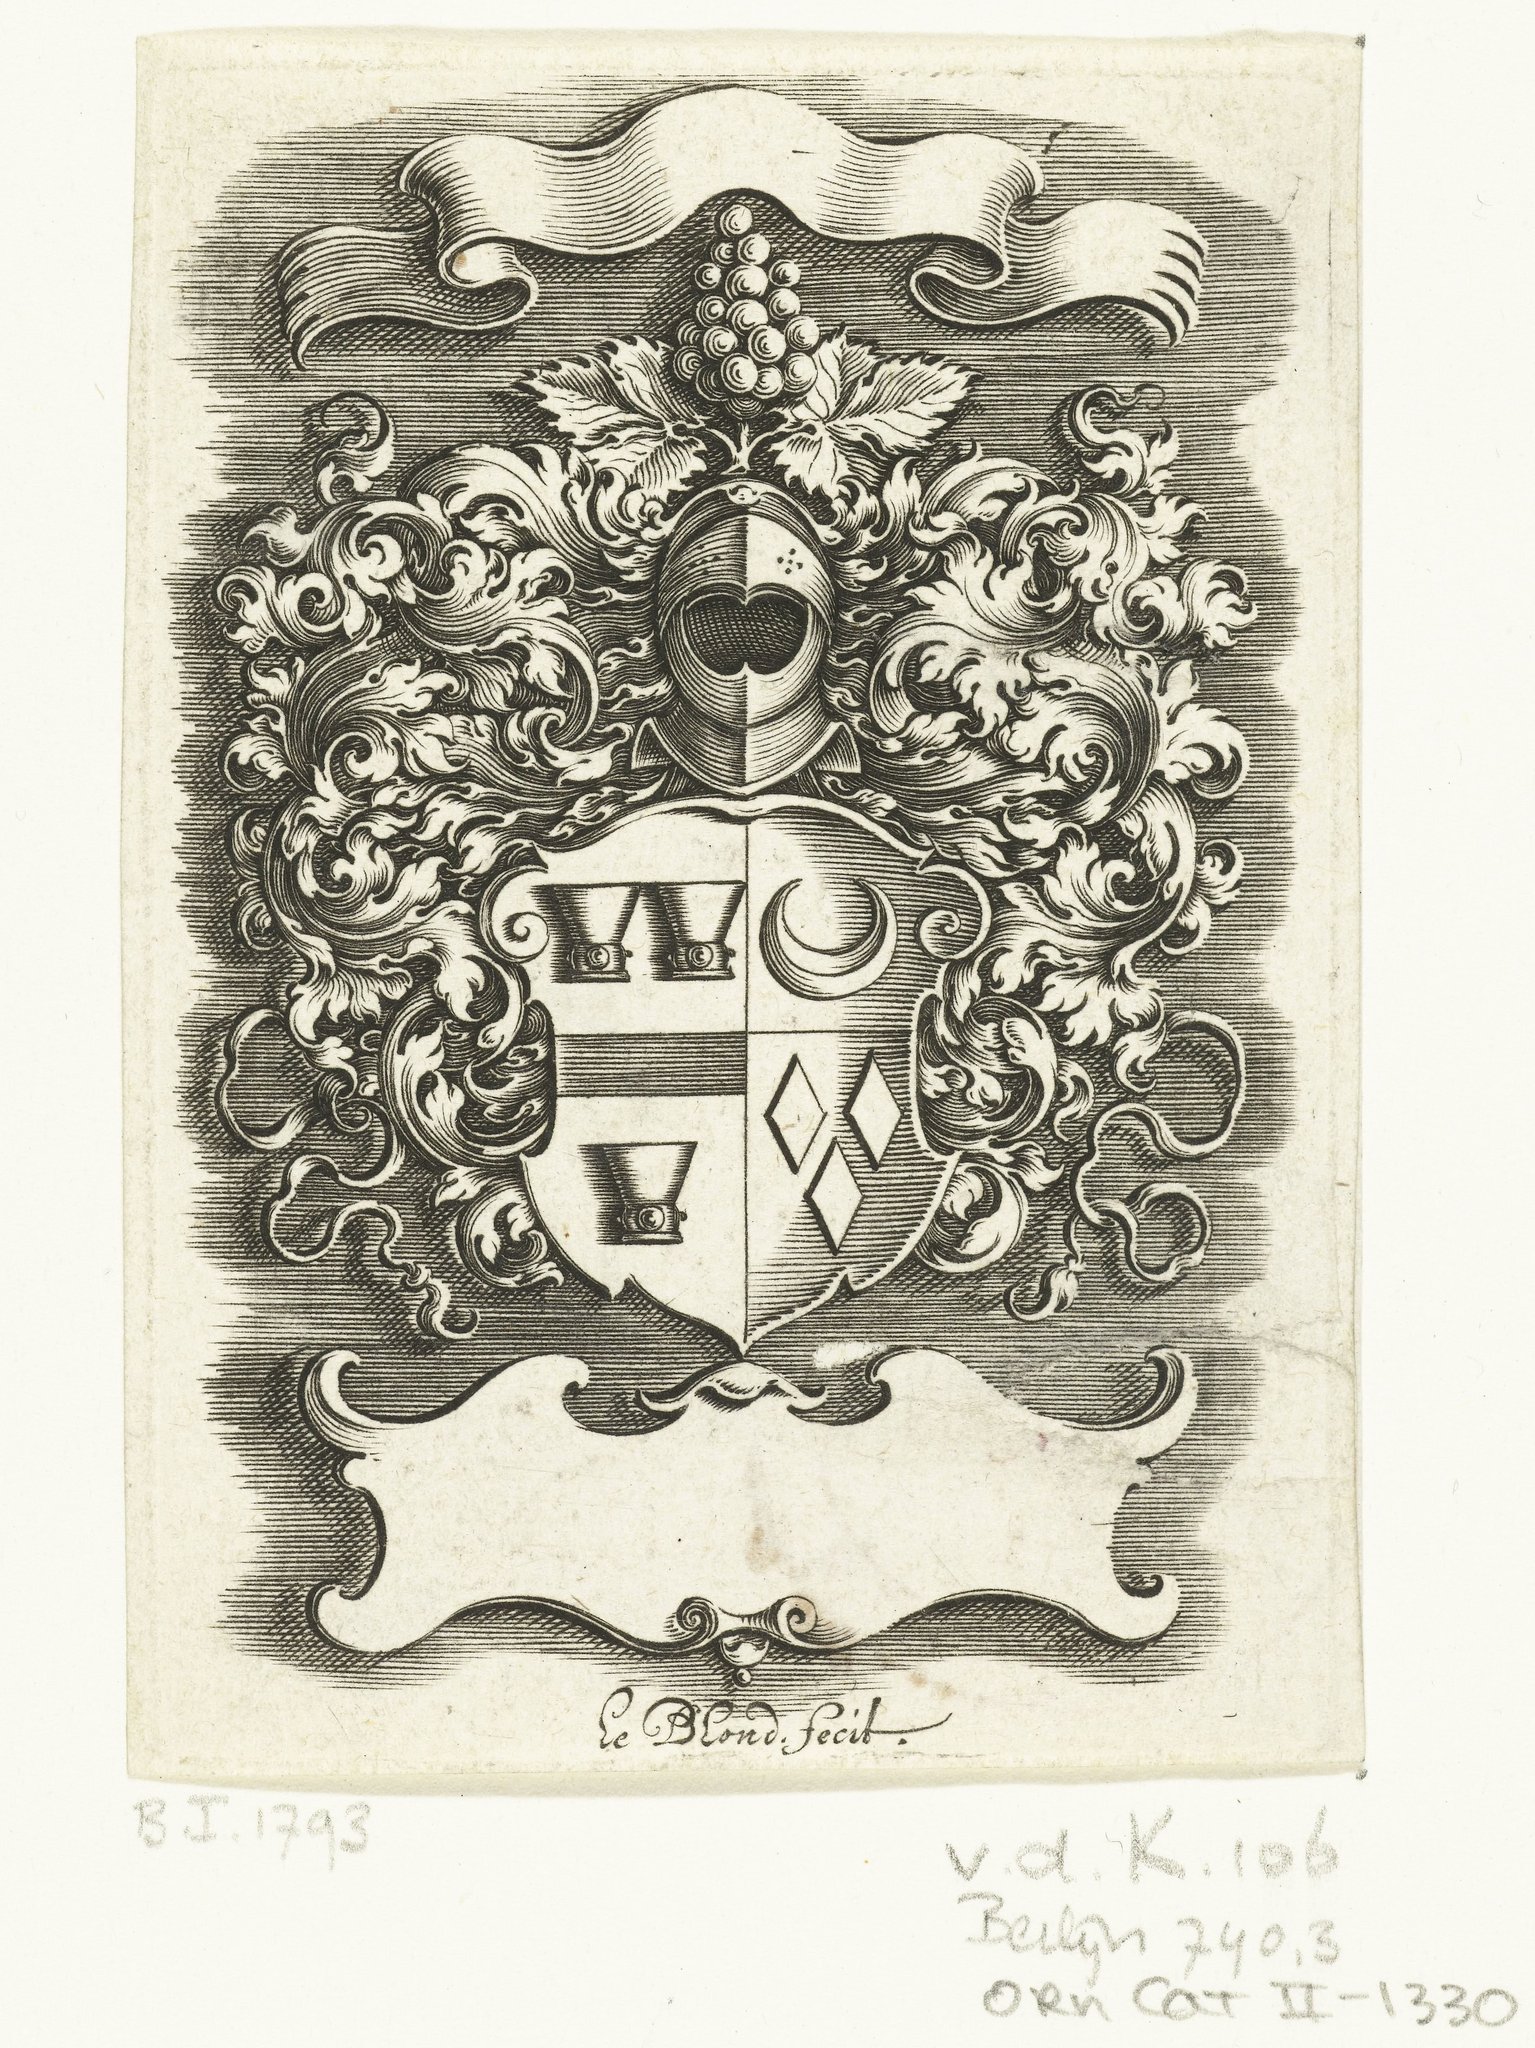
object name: ornament print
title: Wapenschild van Jean Rulant gecombineerd met dat van zijn vrouw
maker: michiel le blon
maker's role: print maker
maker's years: 1587-1656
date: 1611-1625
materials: paper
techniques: engraving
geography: amsterdam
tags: armorial bearing, heraldry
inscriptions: collector's mark: Lugt 240